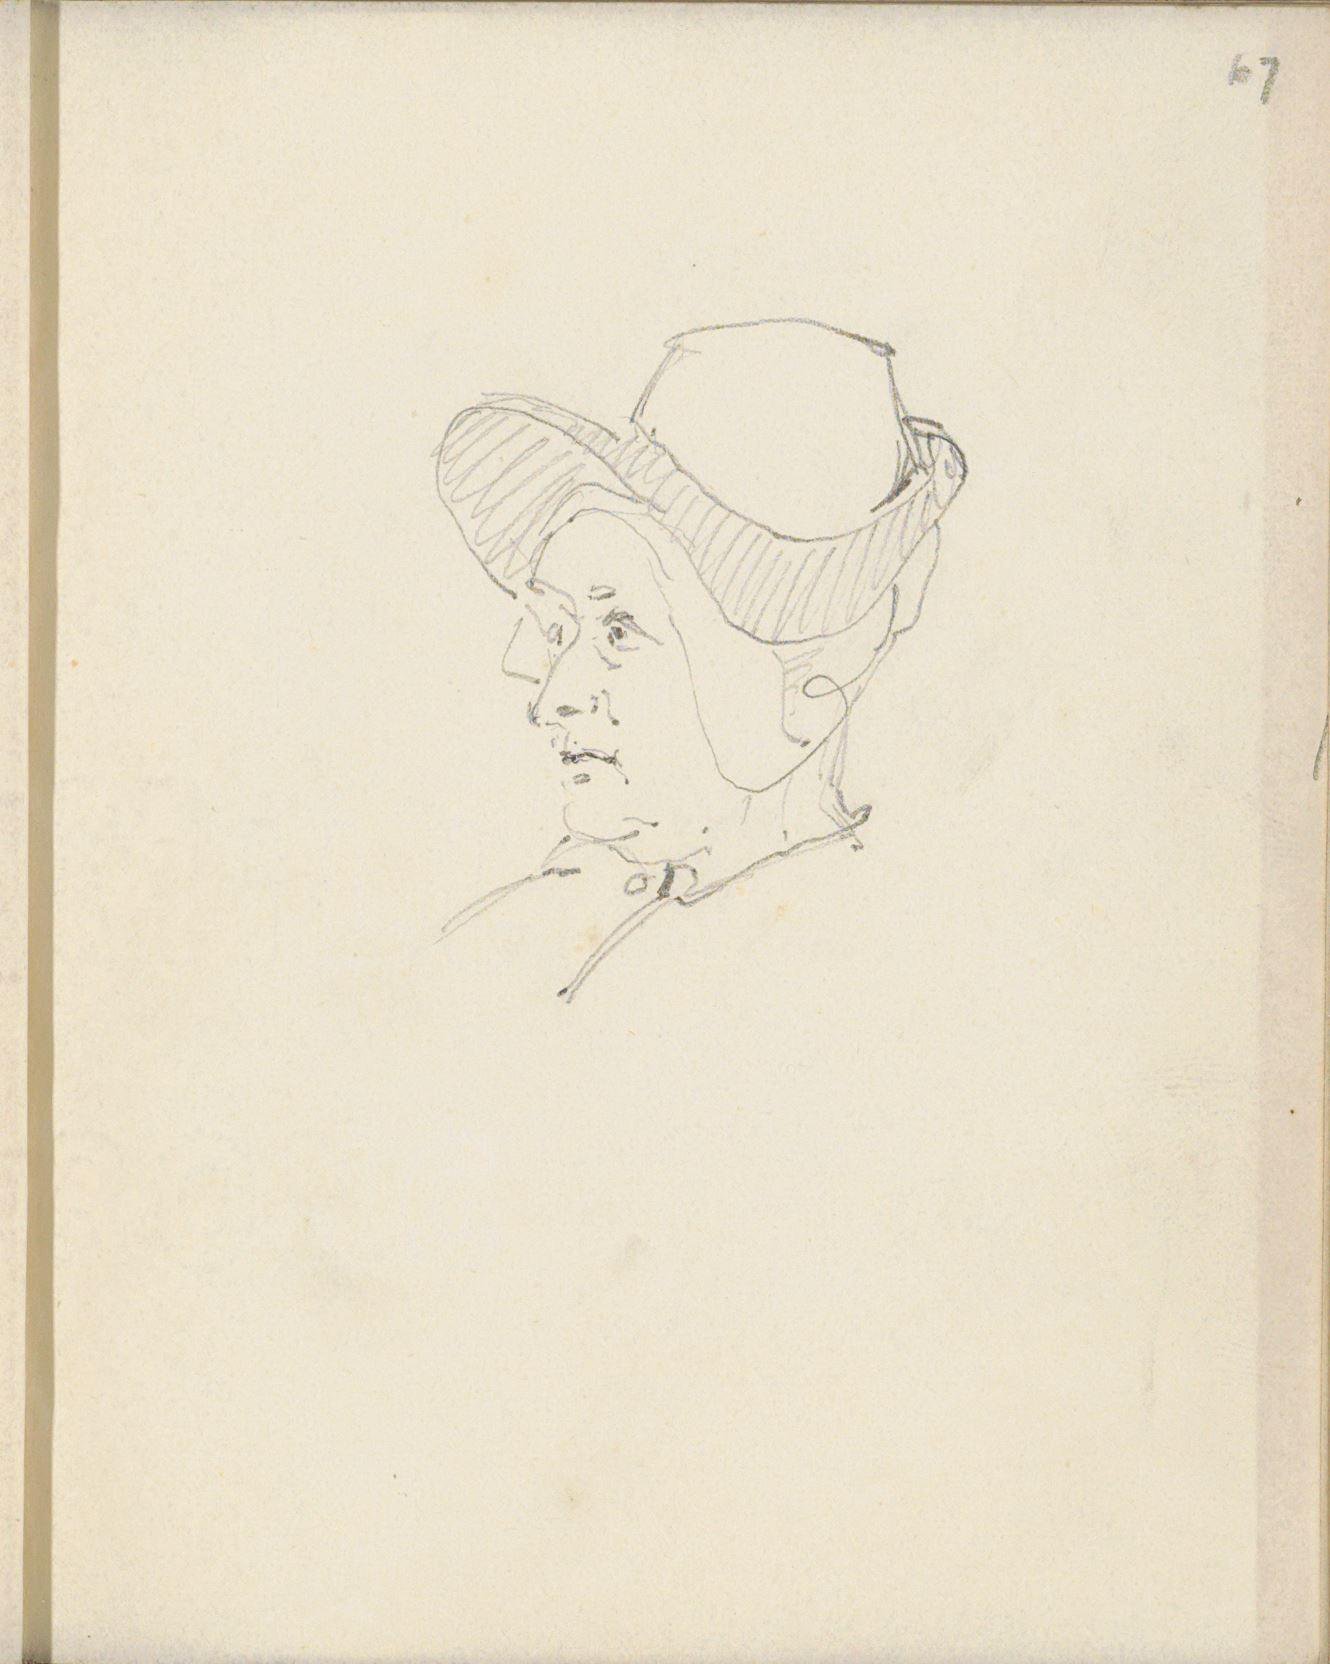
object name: sketchbook leaf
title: Hoofd van een vrouw met een kap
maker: alfred william rich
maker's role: draughtsman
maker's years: 1856-1921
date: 1892-1893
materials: paper, pencil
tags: folk costume, regional costume (+ women's clothes)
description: Blad 67 recto uit een schetsboek met 86 bladen.